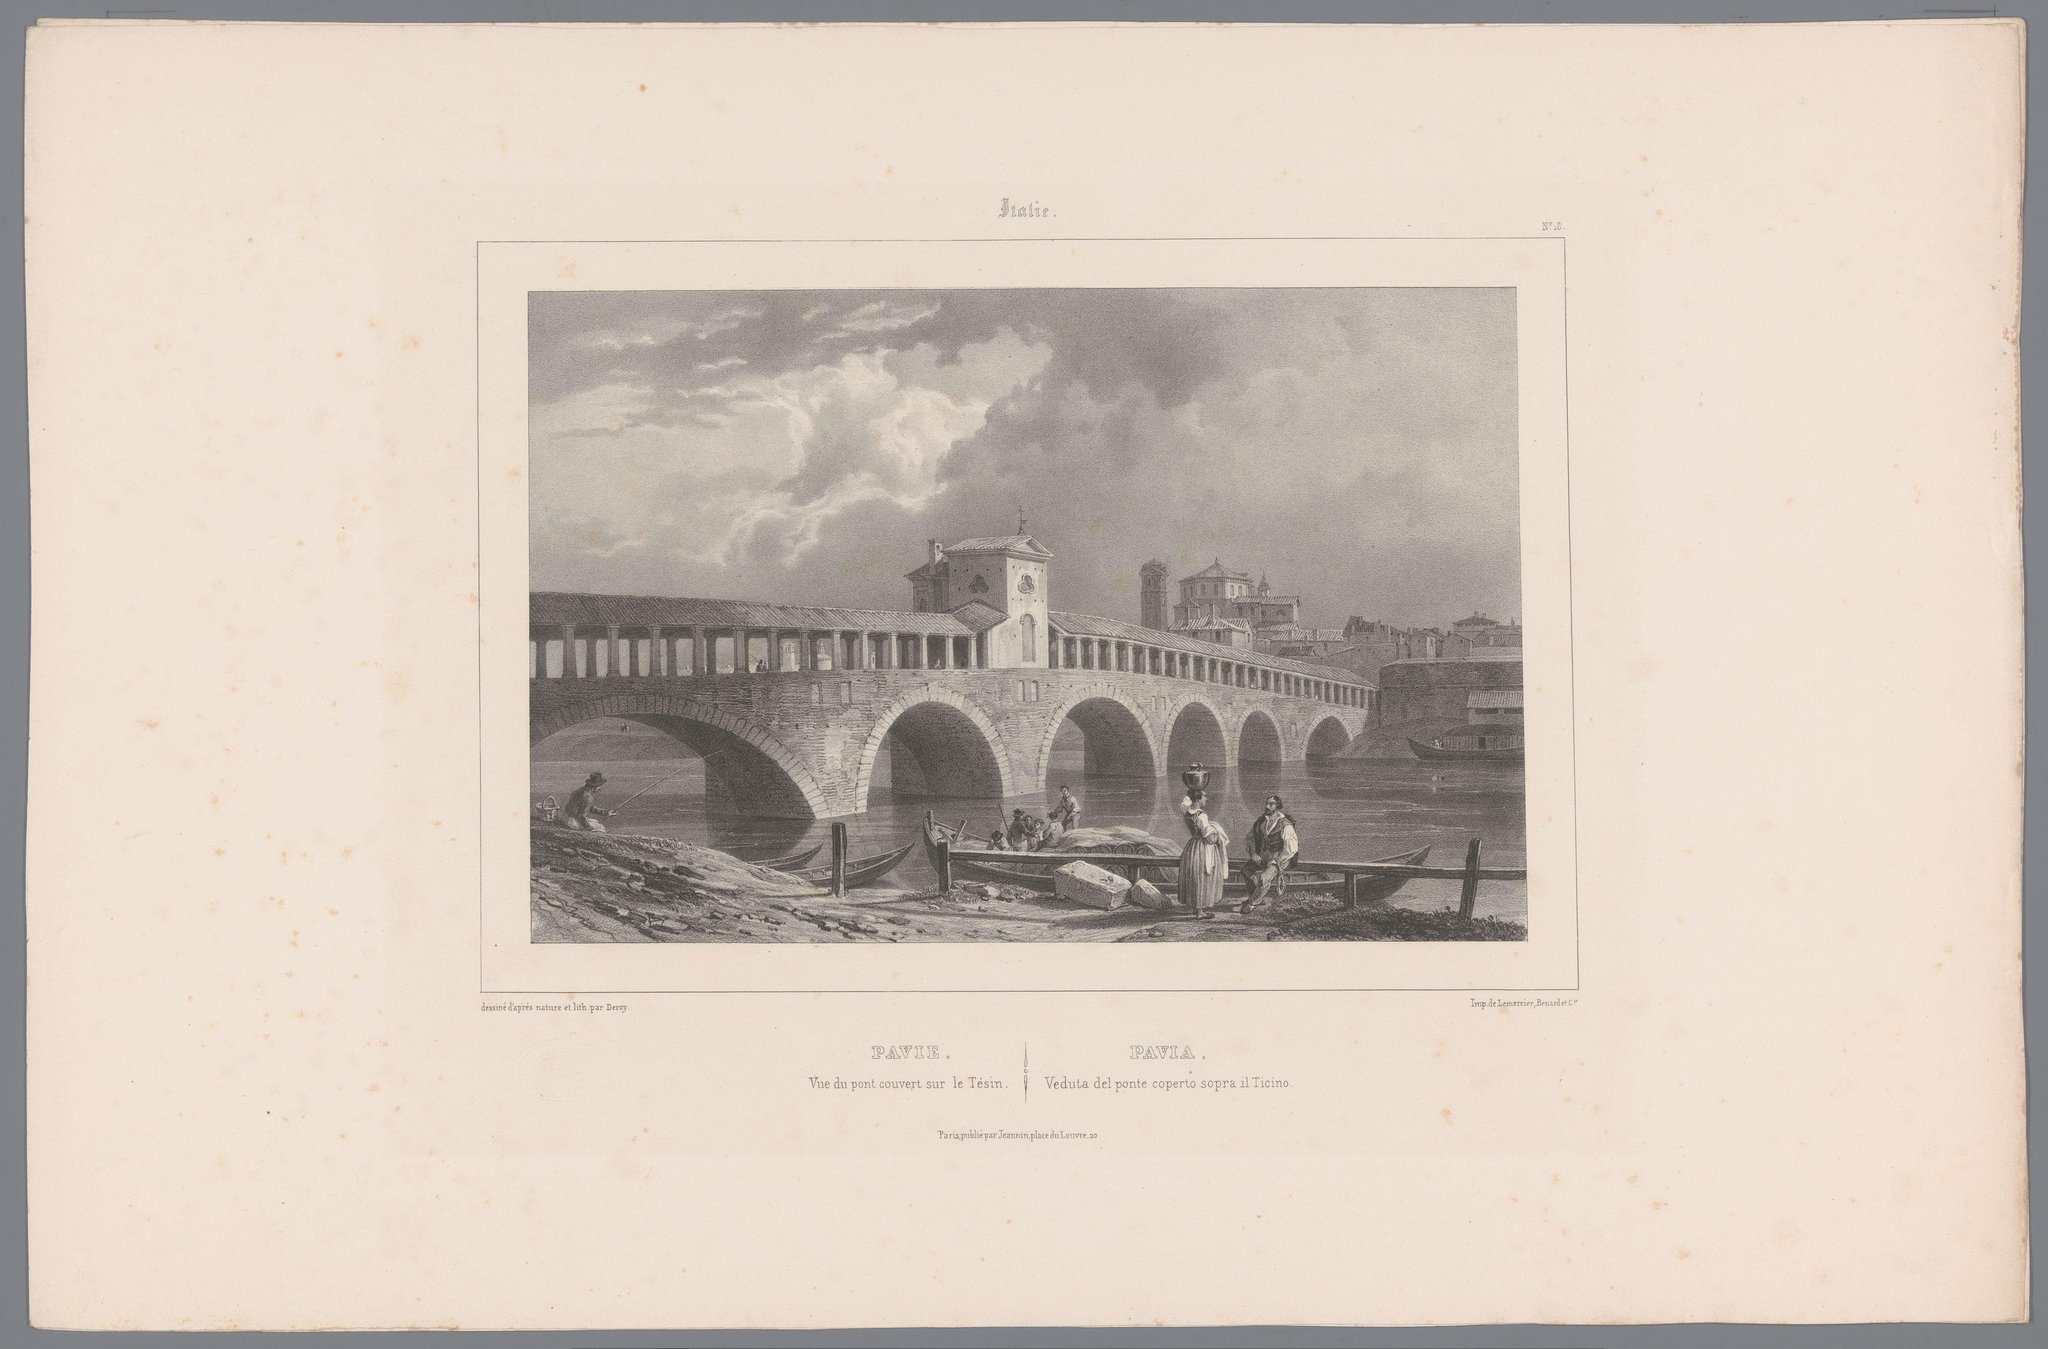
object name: print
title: Zicht op de Ponte Coperto over de Ticino in Pavia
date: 1838-1841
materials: paper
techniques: lithograph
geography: paris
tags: bridge in city across river, canal, etc. (+ city(-scape) with figures, staffage)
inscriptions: check stamp: Lugt 1397c, collector's mark: Lugt 2228a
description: Prent maakt deel uit van een omslag met zes prenten.